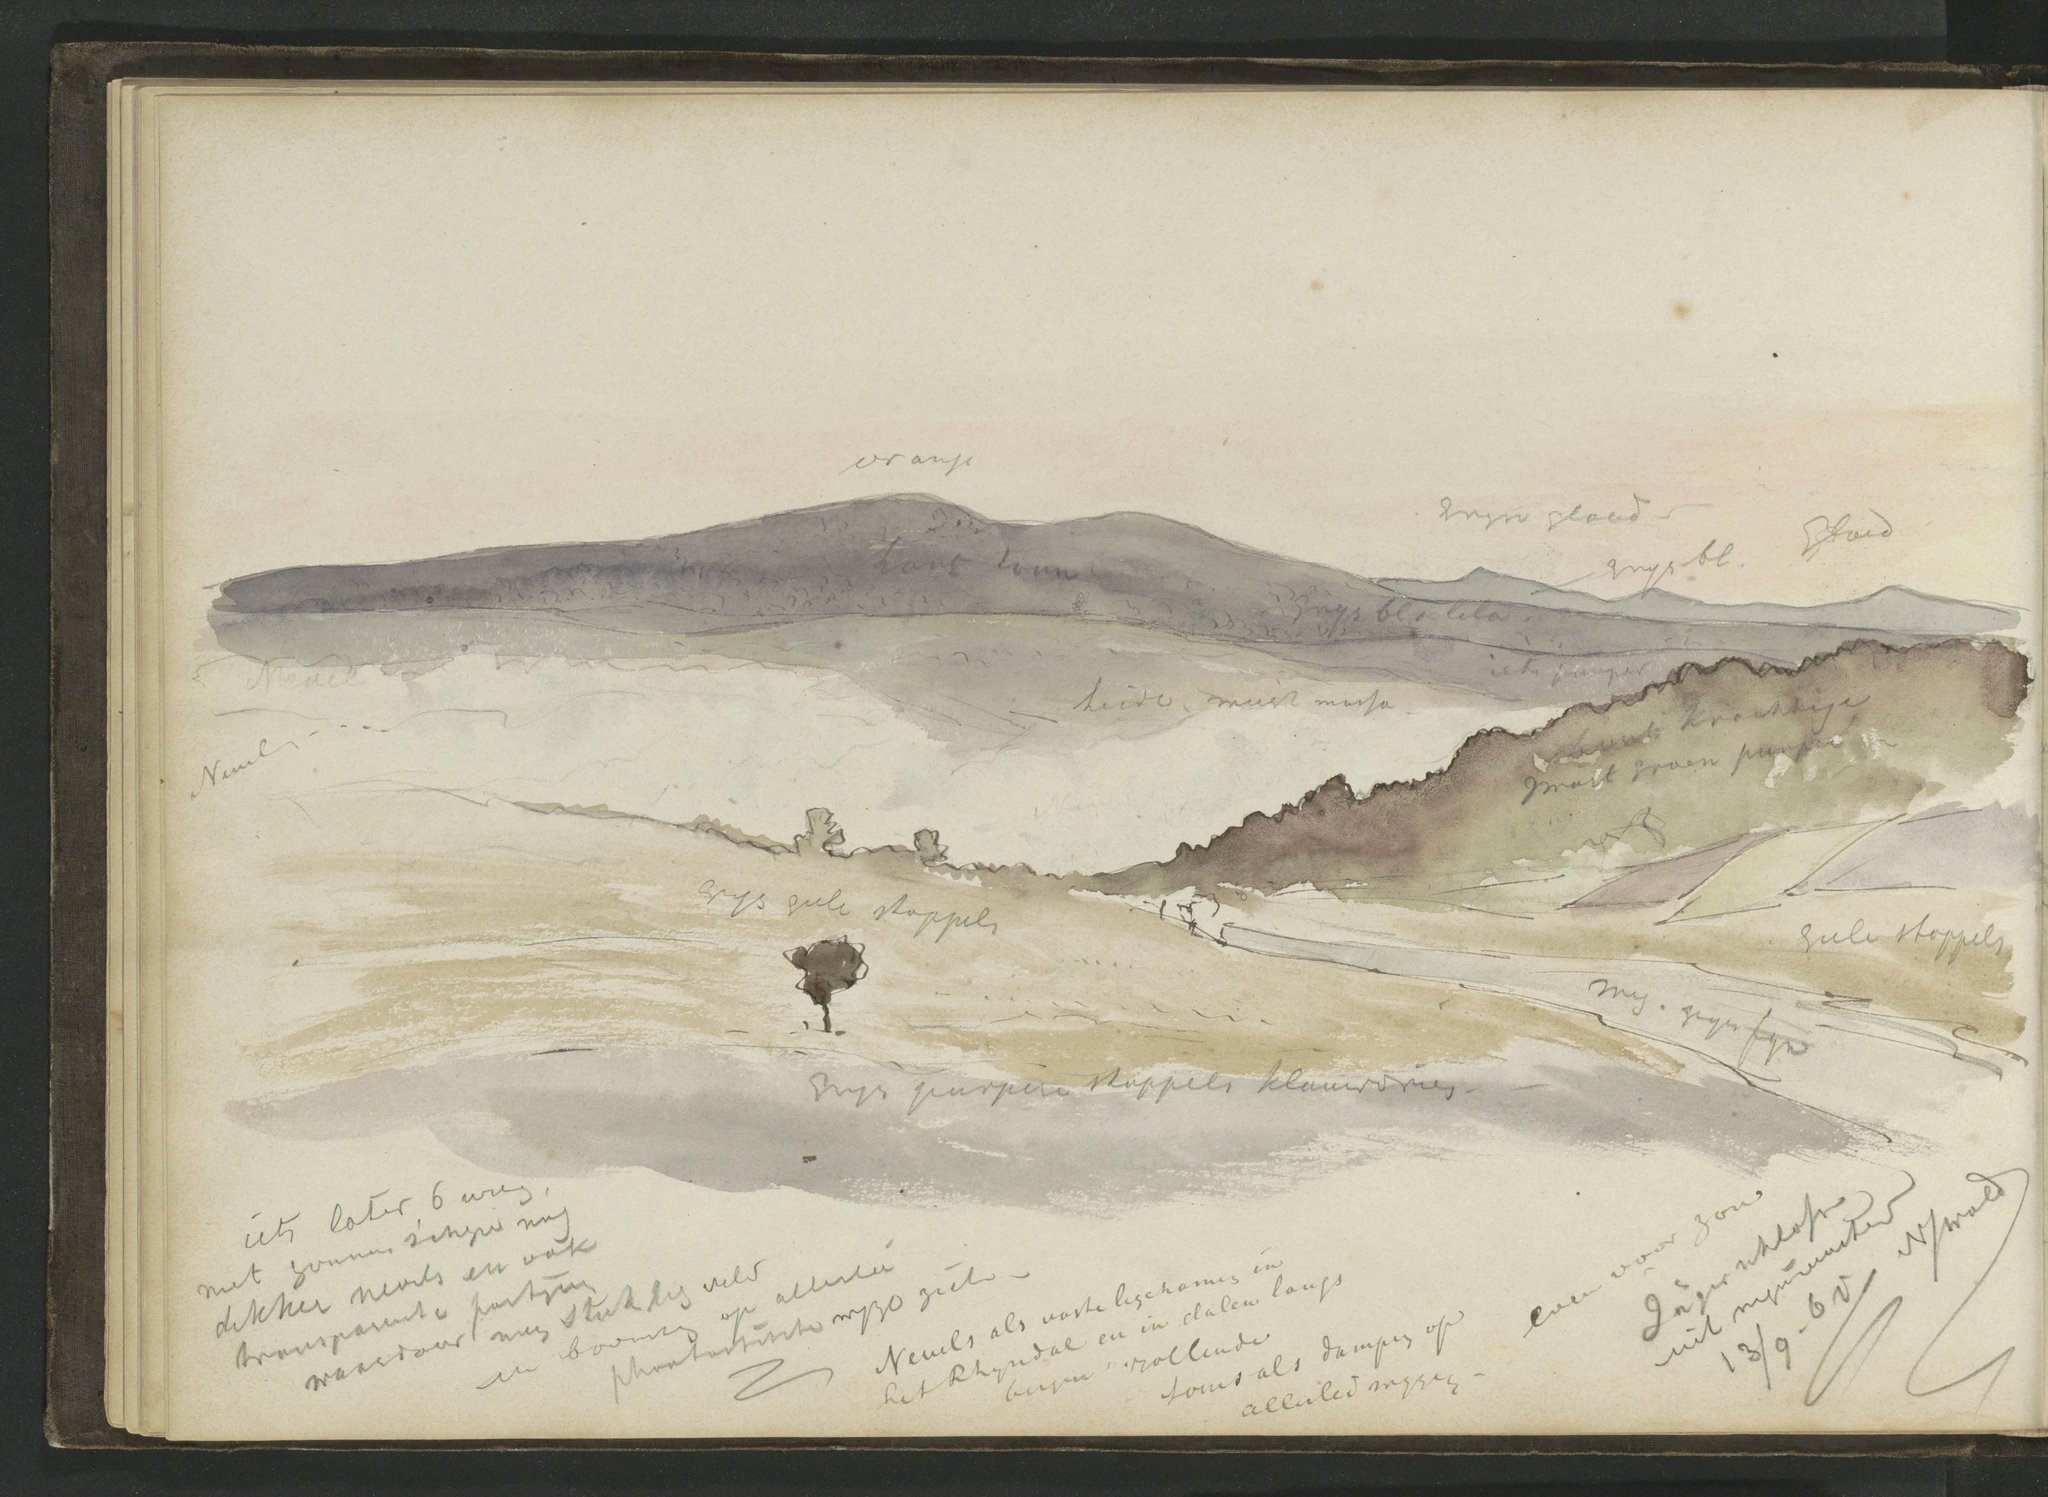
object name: sketchbook leaf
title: Berglandschap met heide in Niederwald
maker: johannes tavenraat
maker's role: draughtsman, painter, print maker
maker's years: 1809-1881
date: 1809-1861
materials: ink, paper, pencil, watercolor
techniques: brush, pen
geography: niederwald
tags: trees, mountains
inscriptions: date and inscription: ‘[...] 13/9 61 N/wald’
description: Blad 23 verso uit een schetsboek met 57 bladen.